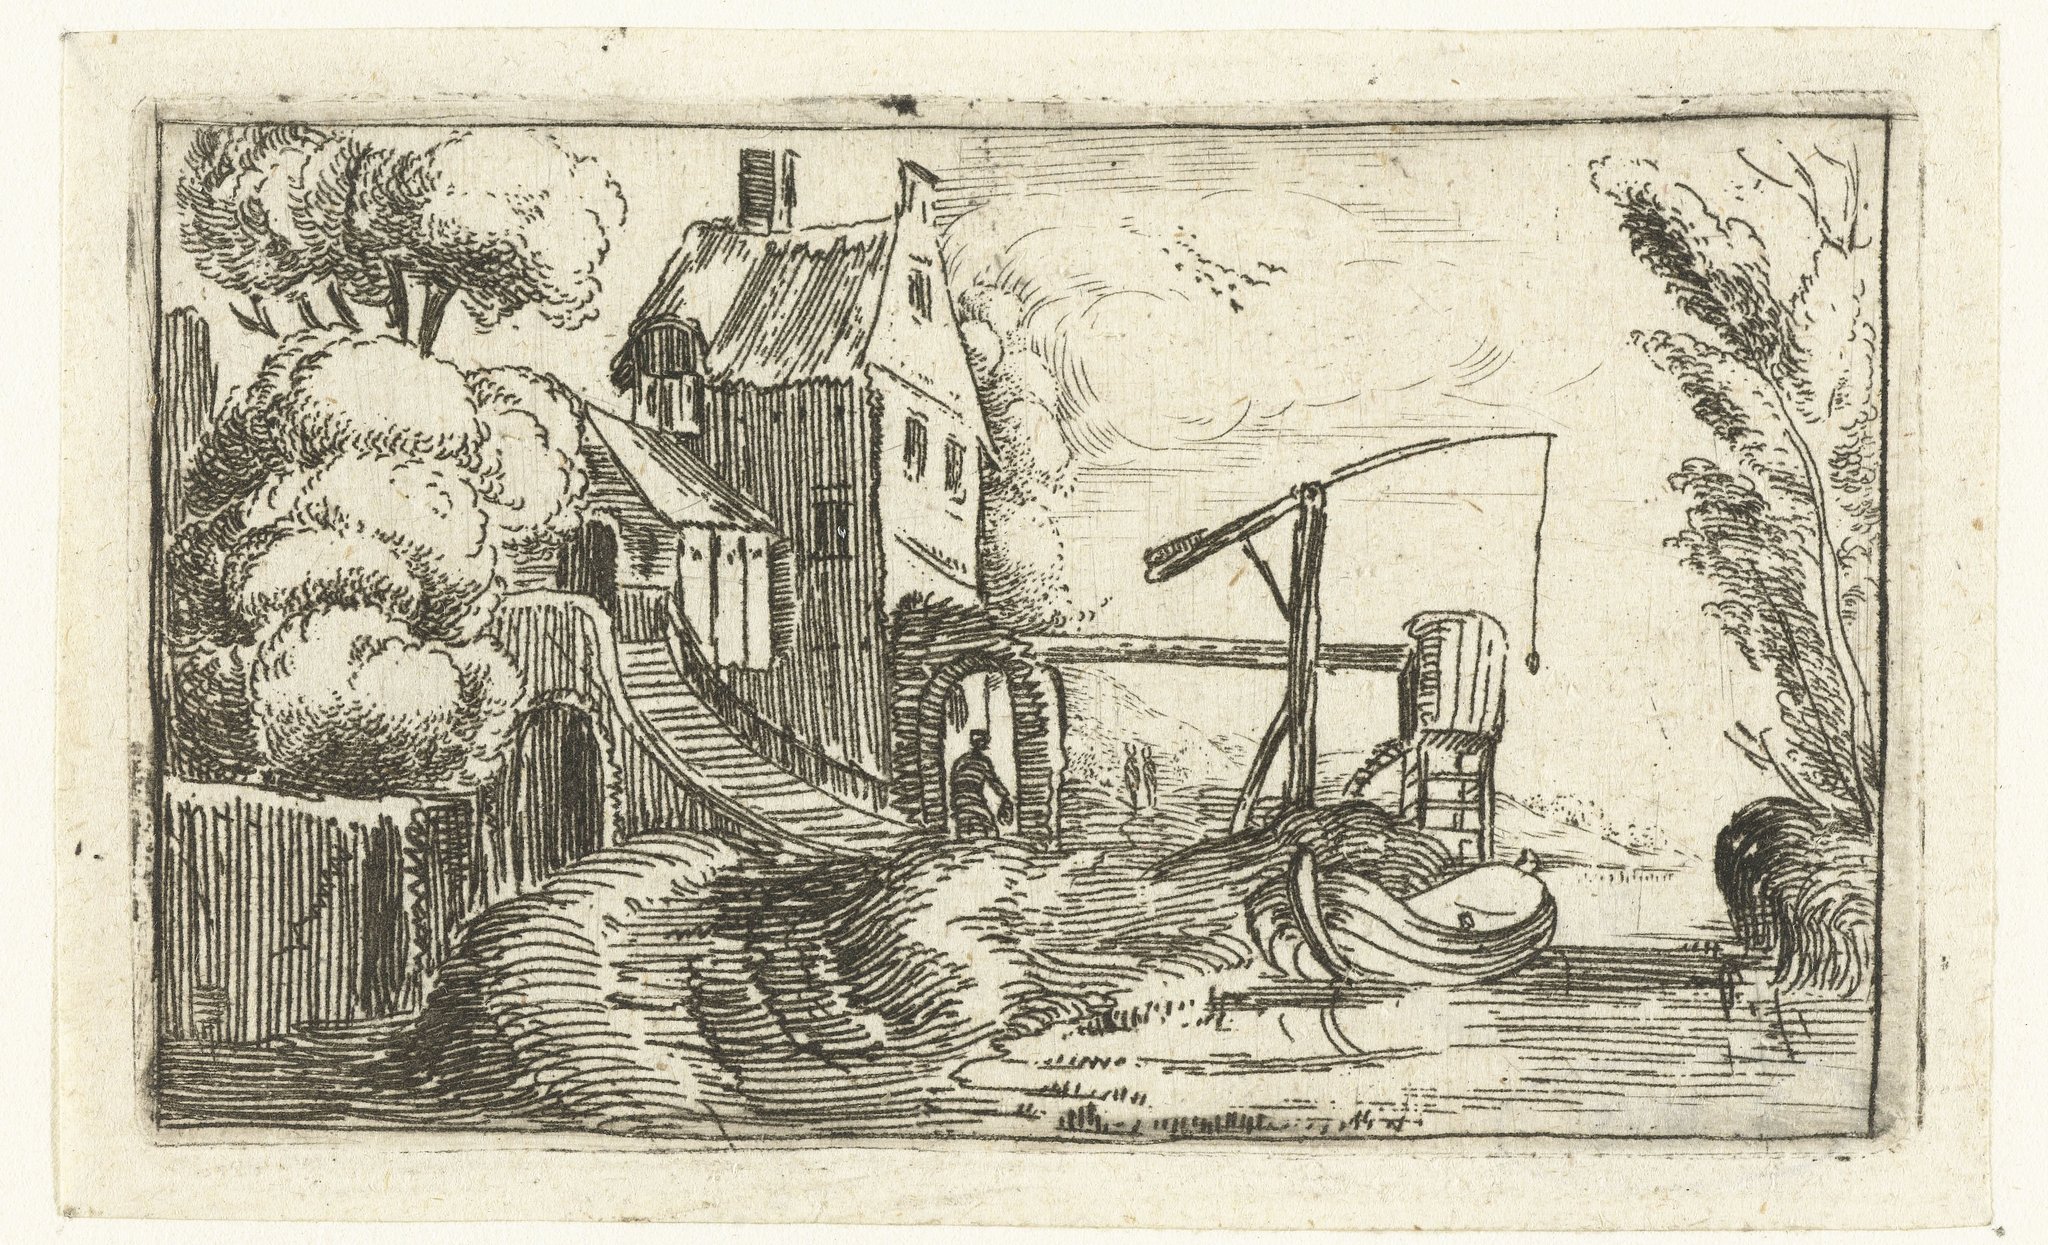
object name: print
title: Huis of fabriek aan een kanaal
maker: Anonymous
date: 1613-1617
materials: paper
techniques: engraving, etching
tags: factories and mills in landscape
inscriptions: collector's mark: Lugt 2228a